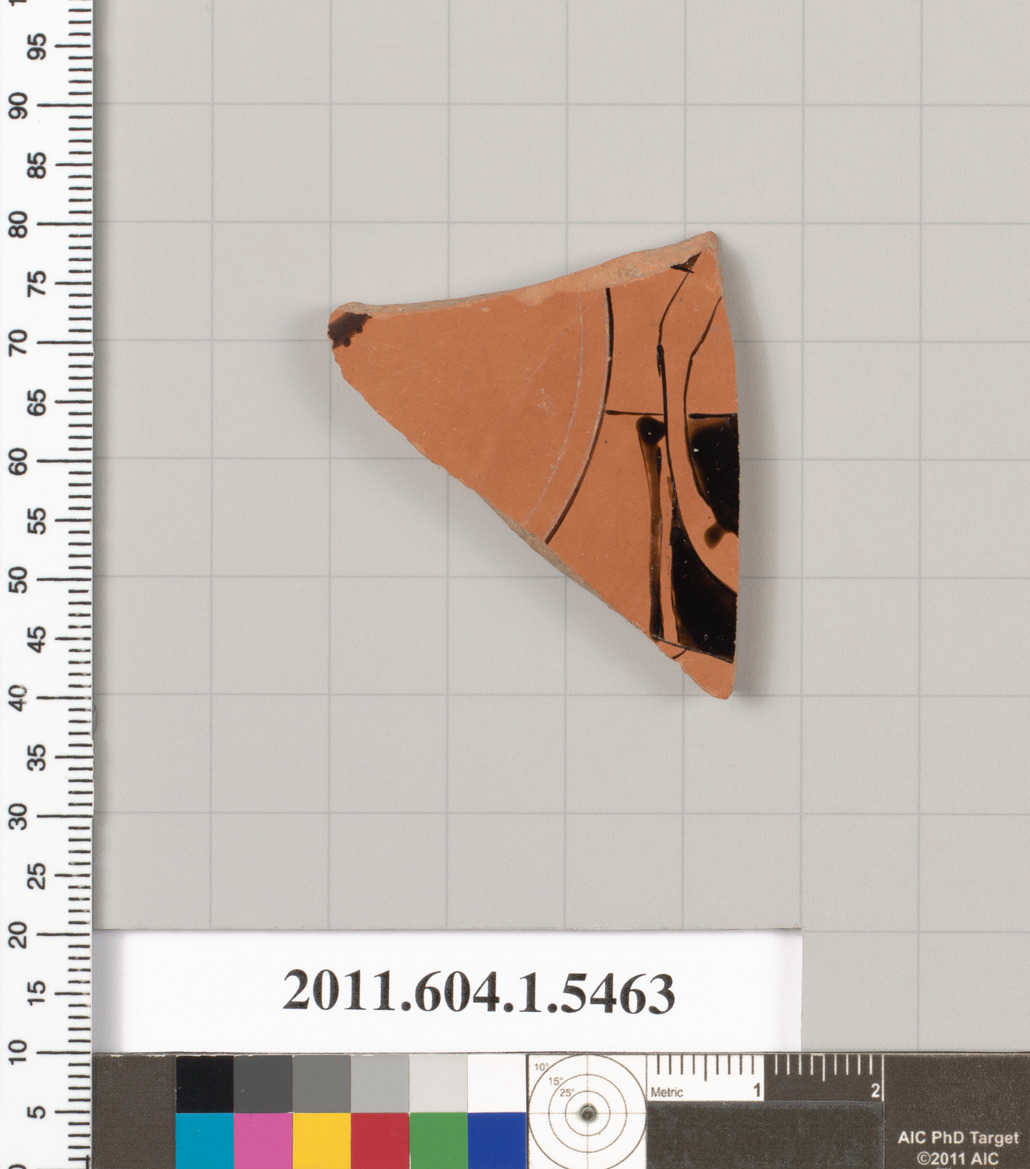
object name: kylix fragment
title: Terracotta fragment of a kylix (drinking cup)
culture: greek, attic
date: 510-500 BCE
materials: terracotta